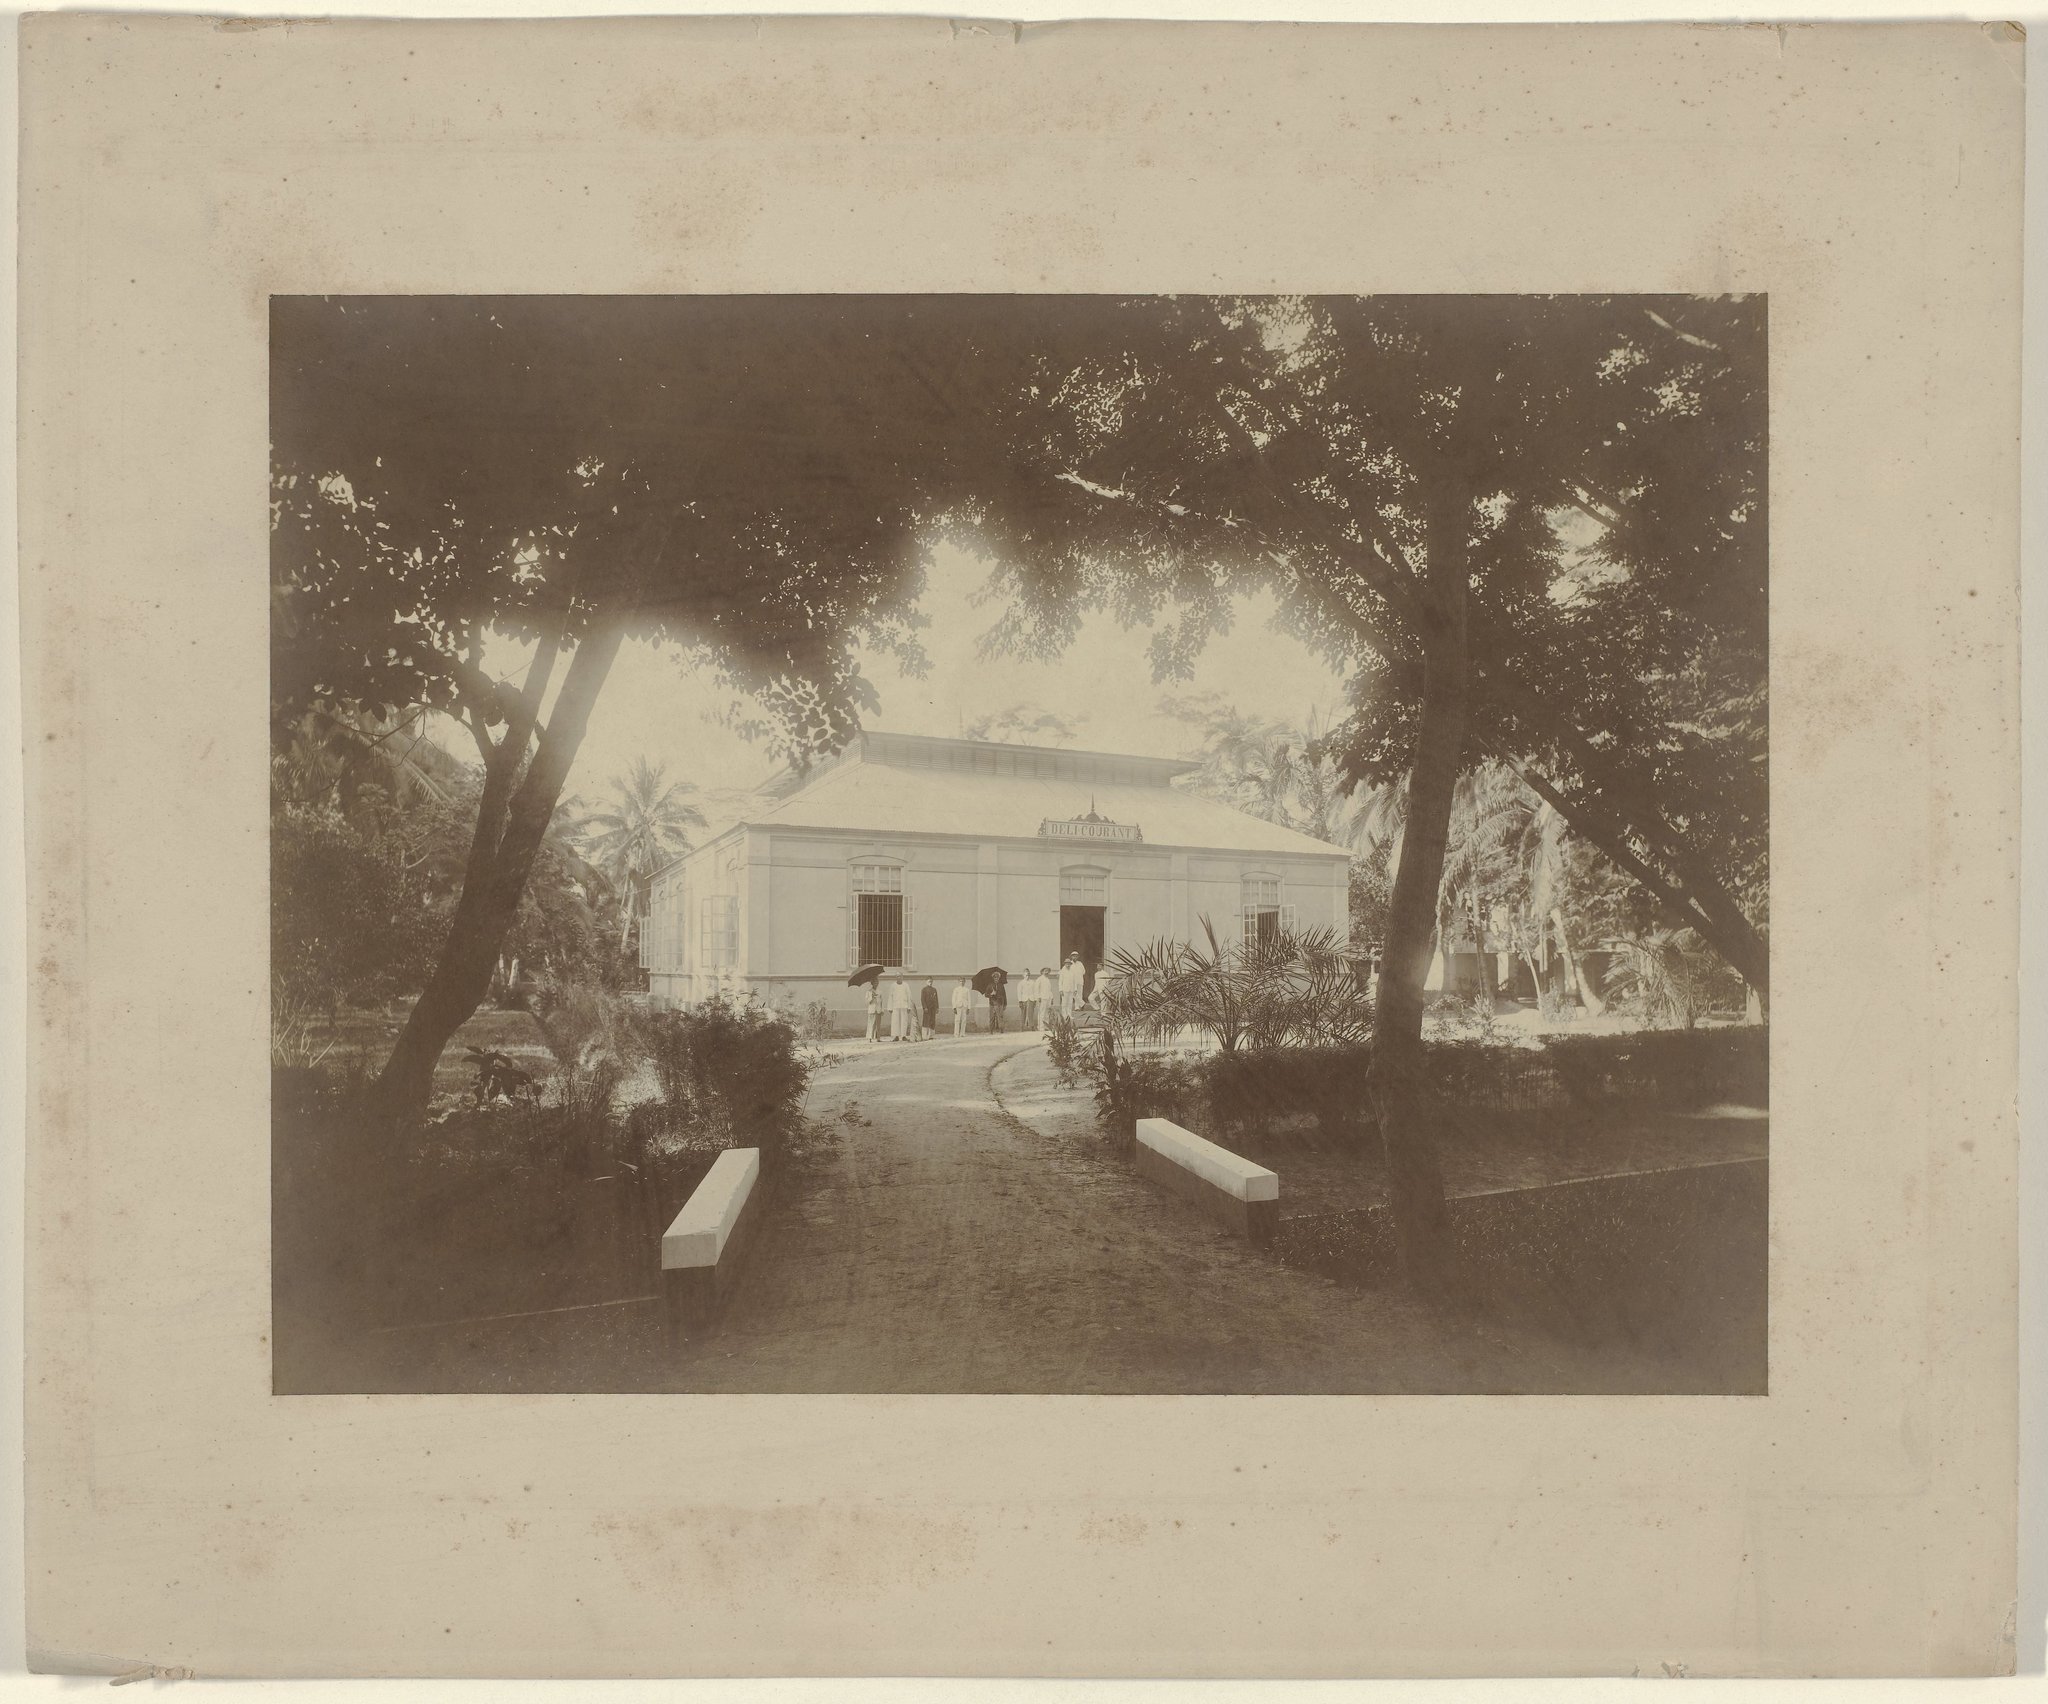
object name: photograph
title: Gebouw van de Deli Courant te Medan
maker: Anonymous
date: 1890-1910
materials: cardboard, photographic support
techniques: gelatin silver print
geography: medan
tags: dutch east indies, the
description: Gezicht op een gebouw van de Deli Courant te Medan. Voor de ingang poseren werknemers, het gebouw omringd door bomen. Onderdeel van een groep van 49 losse zwart-wit foto's van verschillend formaat over de uitgeverij en drukkerij van de krant Deli Courant in Medan in de periode 1885-1947.